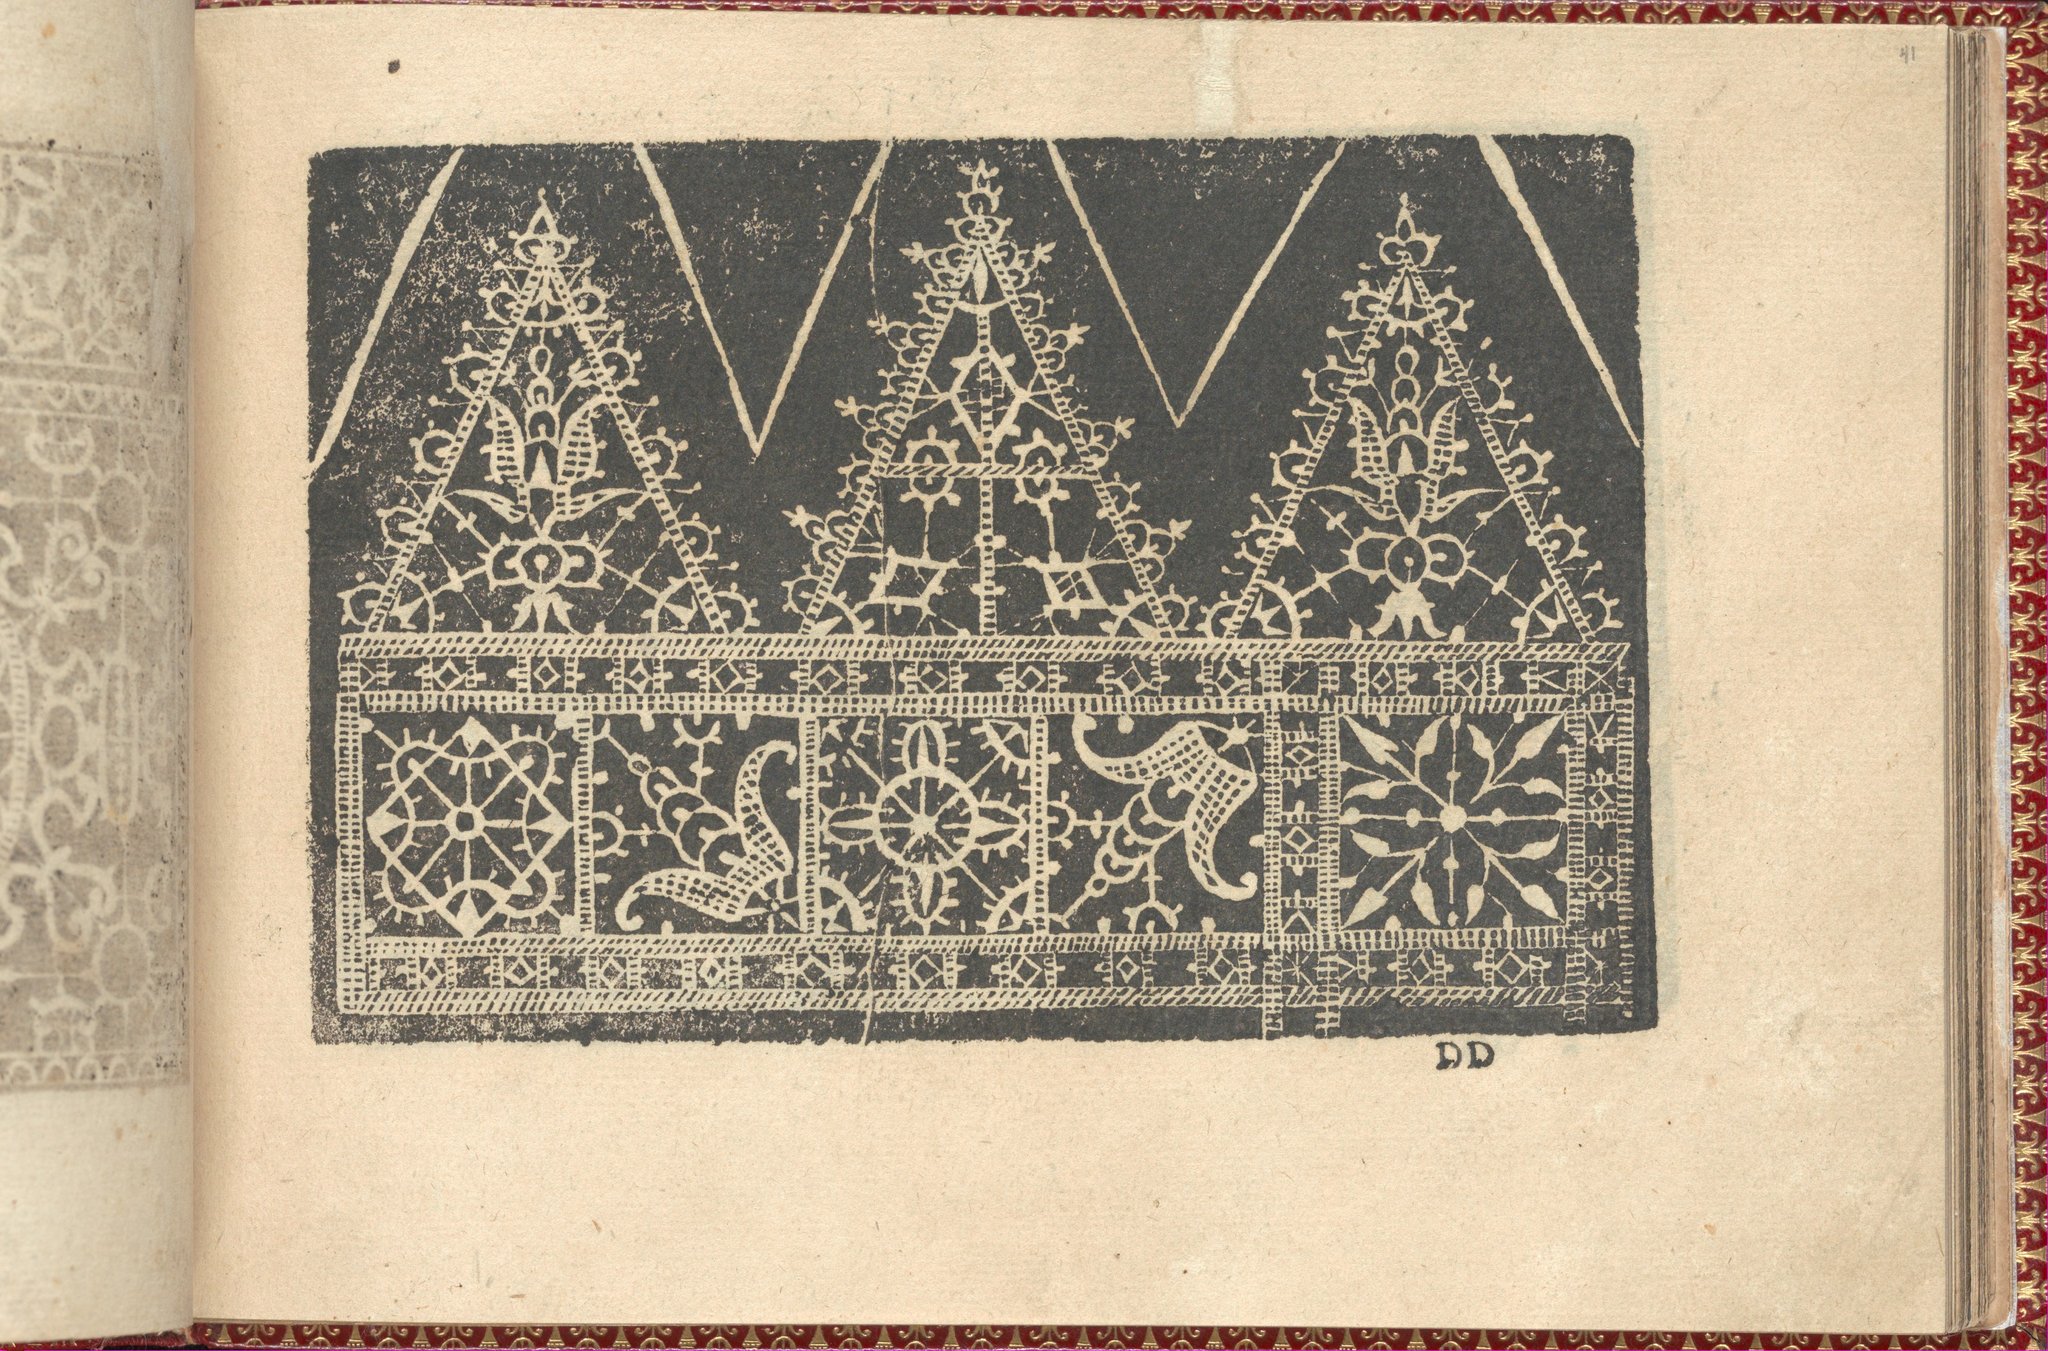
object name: book print ornament architecture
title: Corona delle Nobili et Virtuose Donne: Libro I-IV, page 41 (recto)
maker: cesare vecellio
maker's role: publisher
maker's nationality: italian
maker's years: 1521-1601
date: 1601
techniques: woodcut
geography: italy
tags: ornament